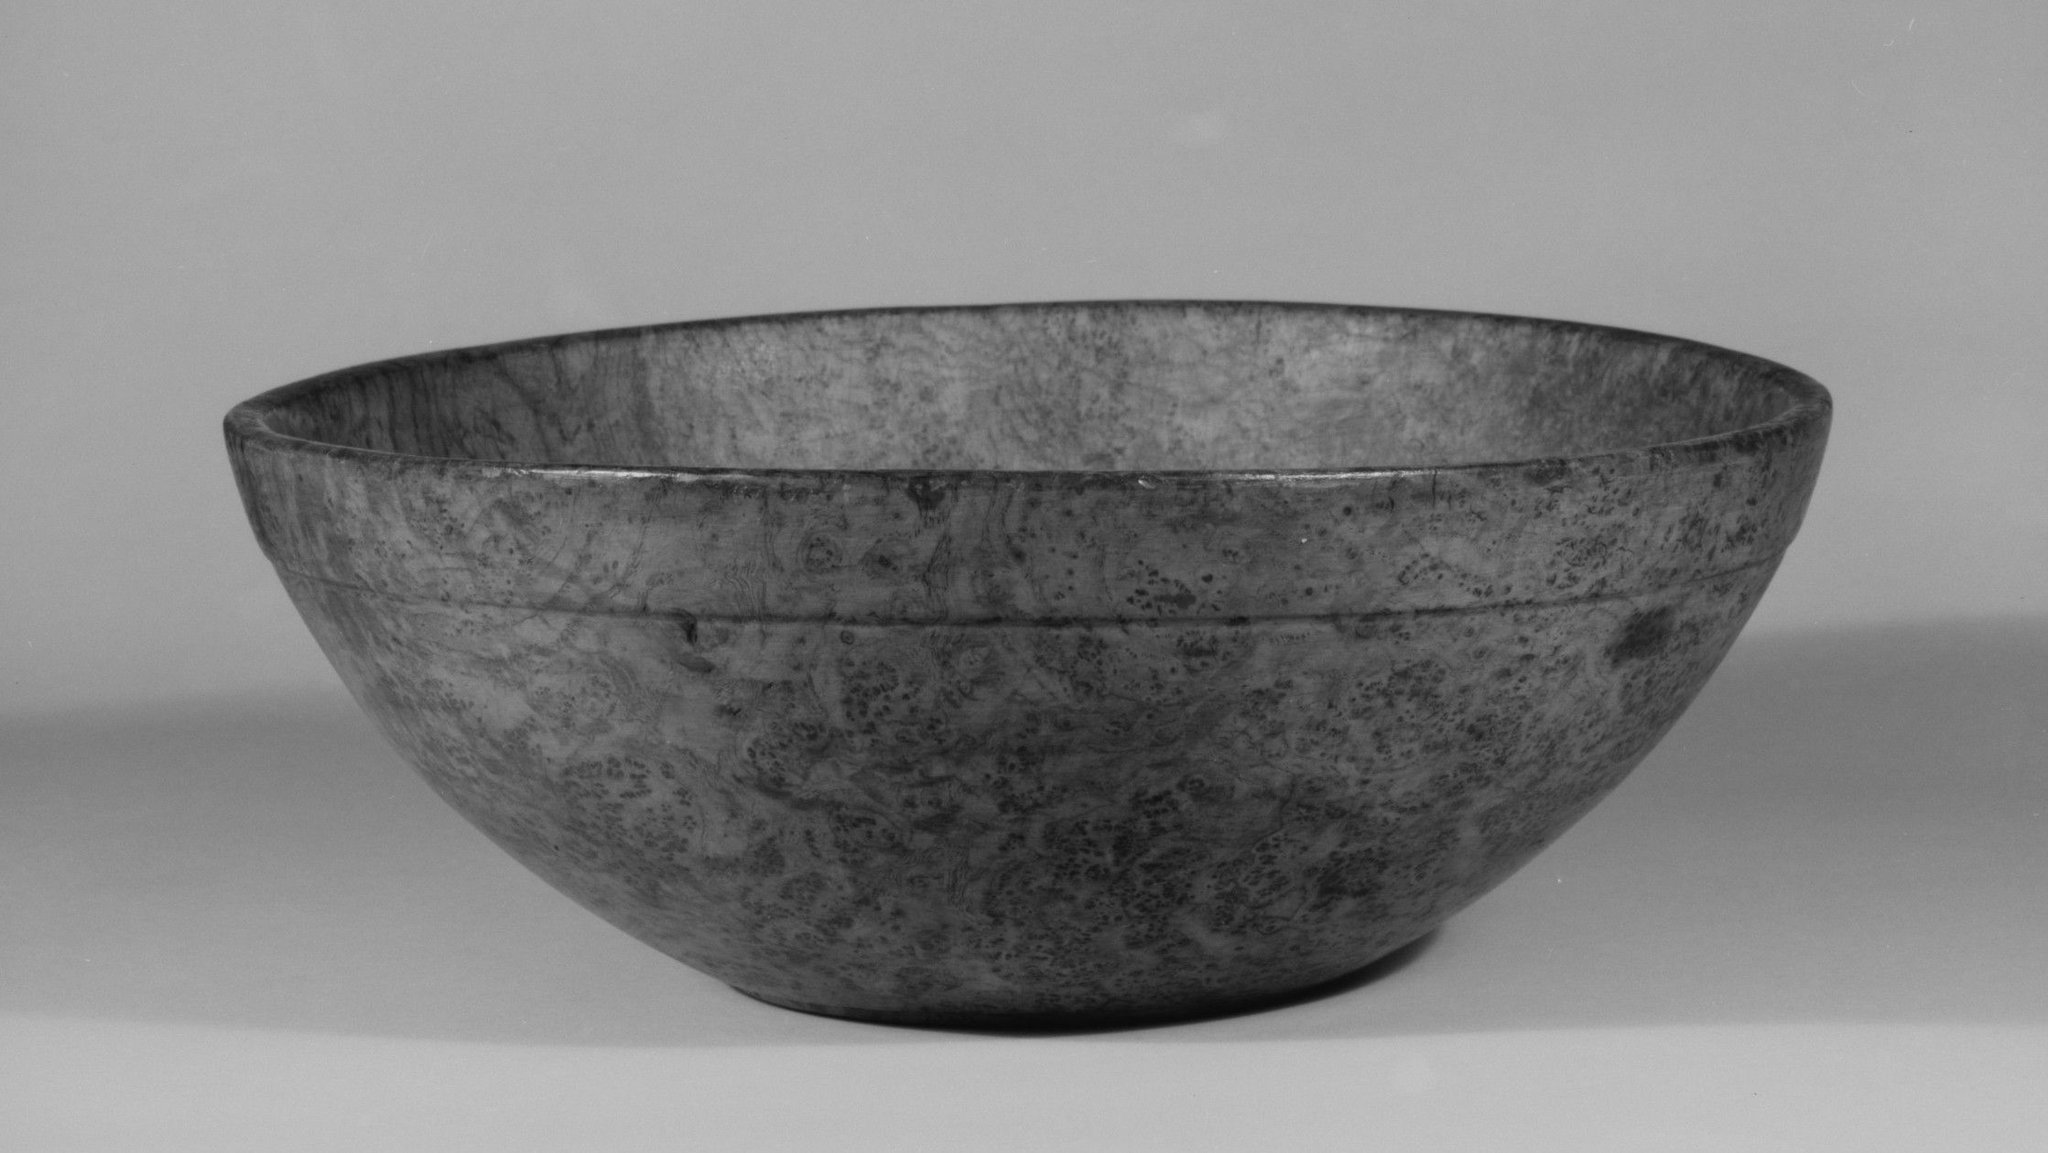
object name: bowl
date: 1820